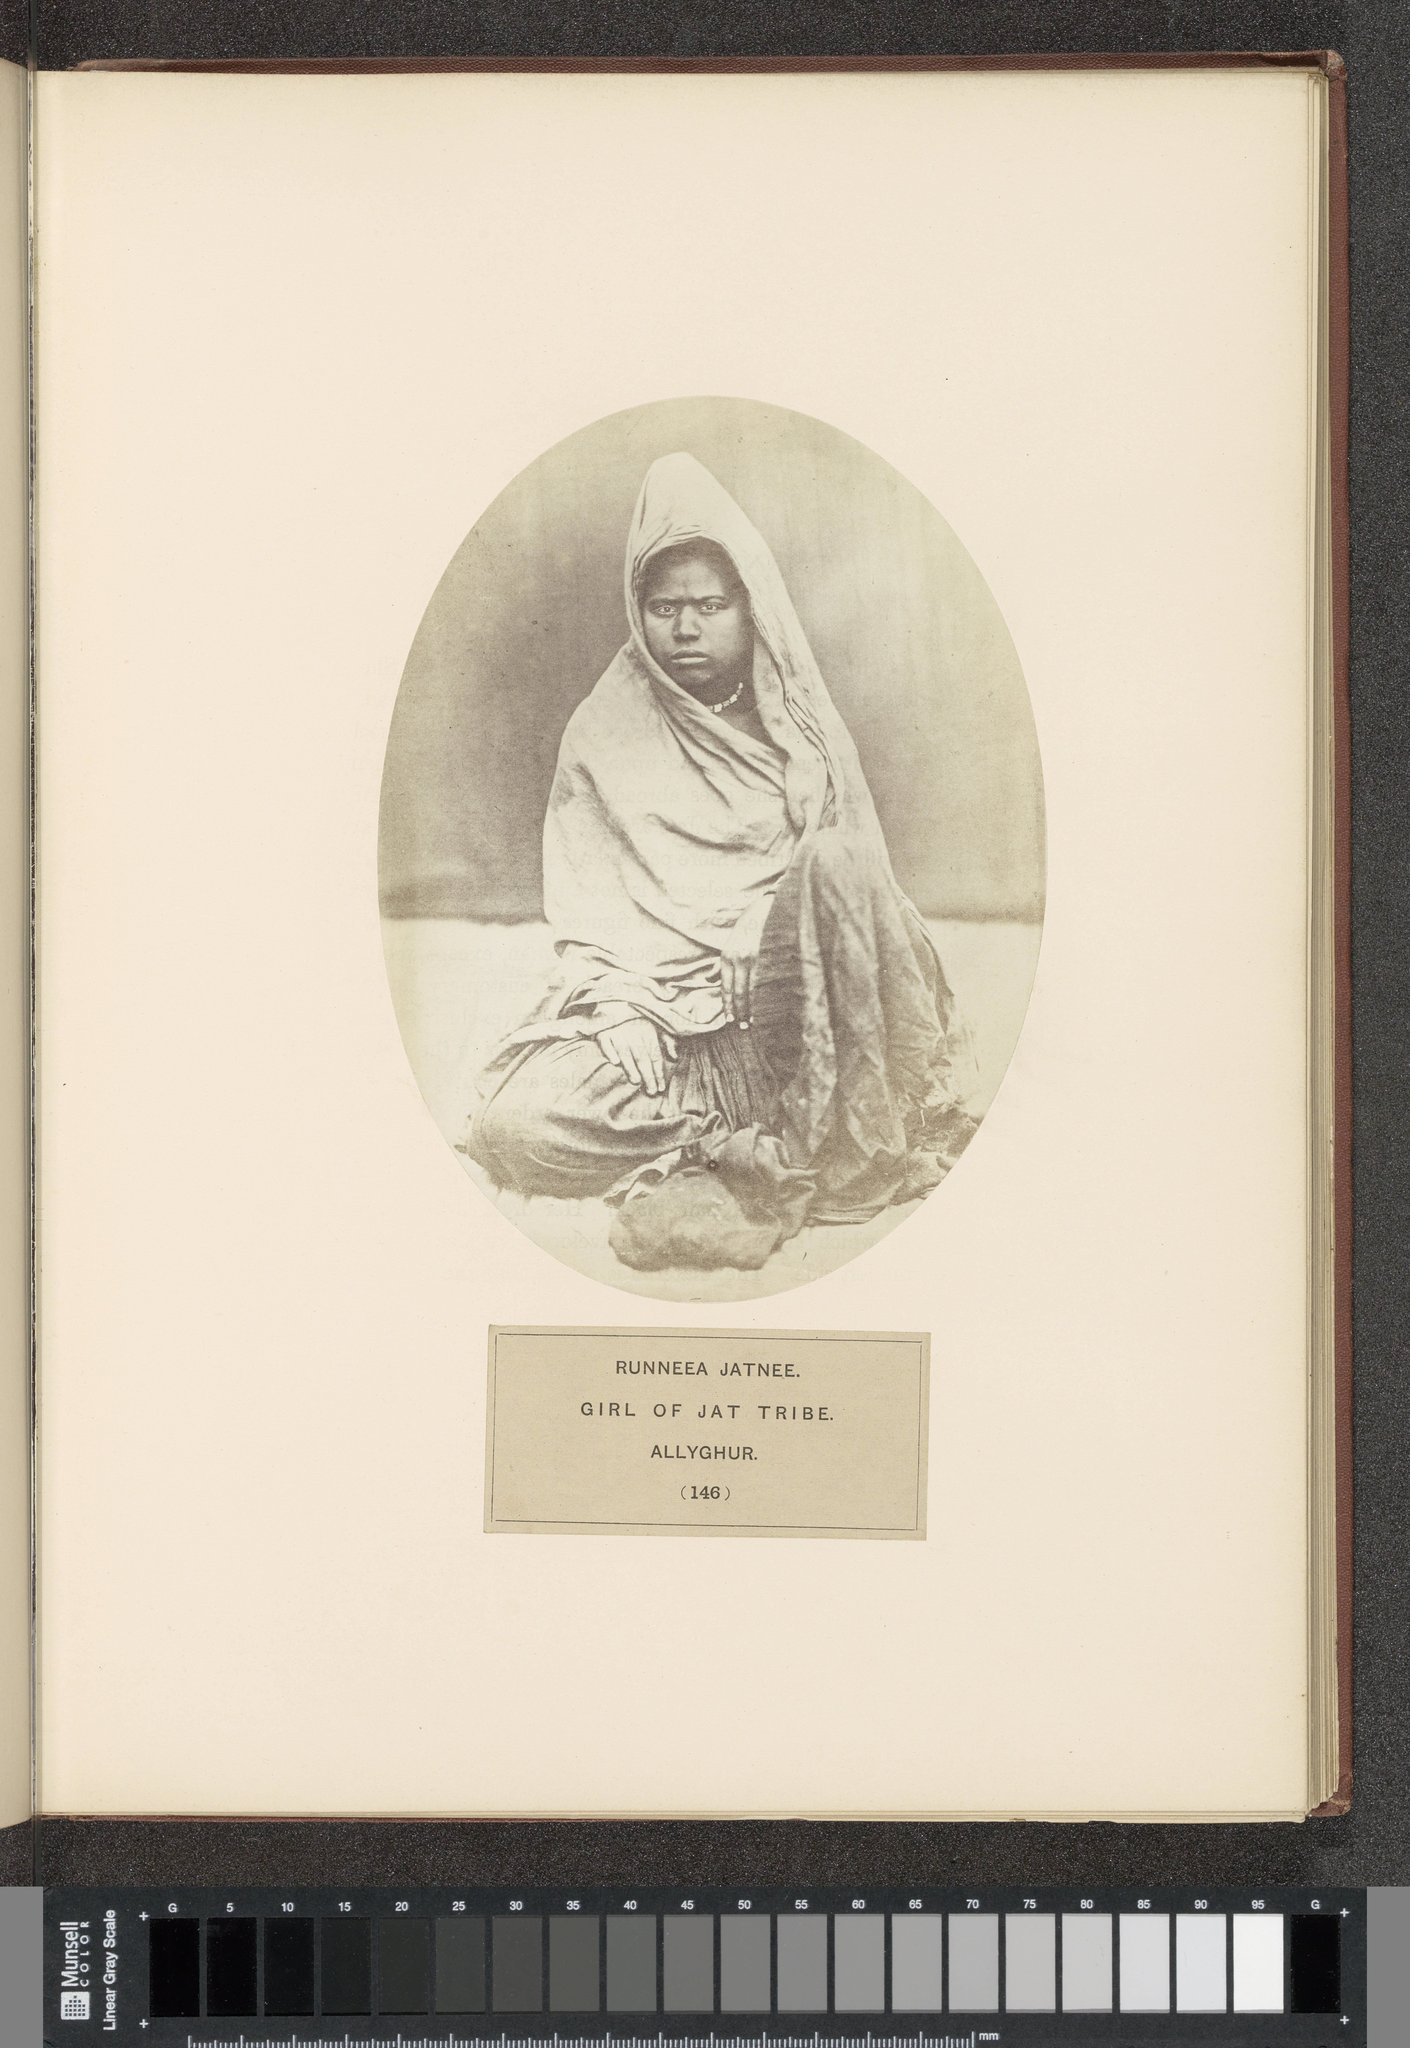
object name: photograph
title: Portrait of Runneea, a woman from the Jat community of Aligarh, Uttar Pradesh, India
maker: Anonymous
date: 1858-1868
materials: photographic support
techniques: albumen print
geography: aligarh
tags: human races; peoples; nationalities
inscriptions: number: ‘(146)’, inscription: ‘RUNNEEA JATNEE./ GIRL OF JAT TRIBE./ ALLYGHUR.’